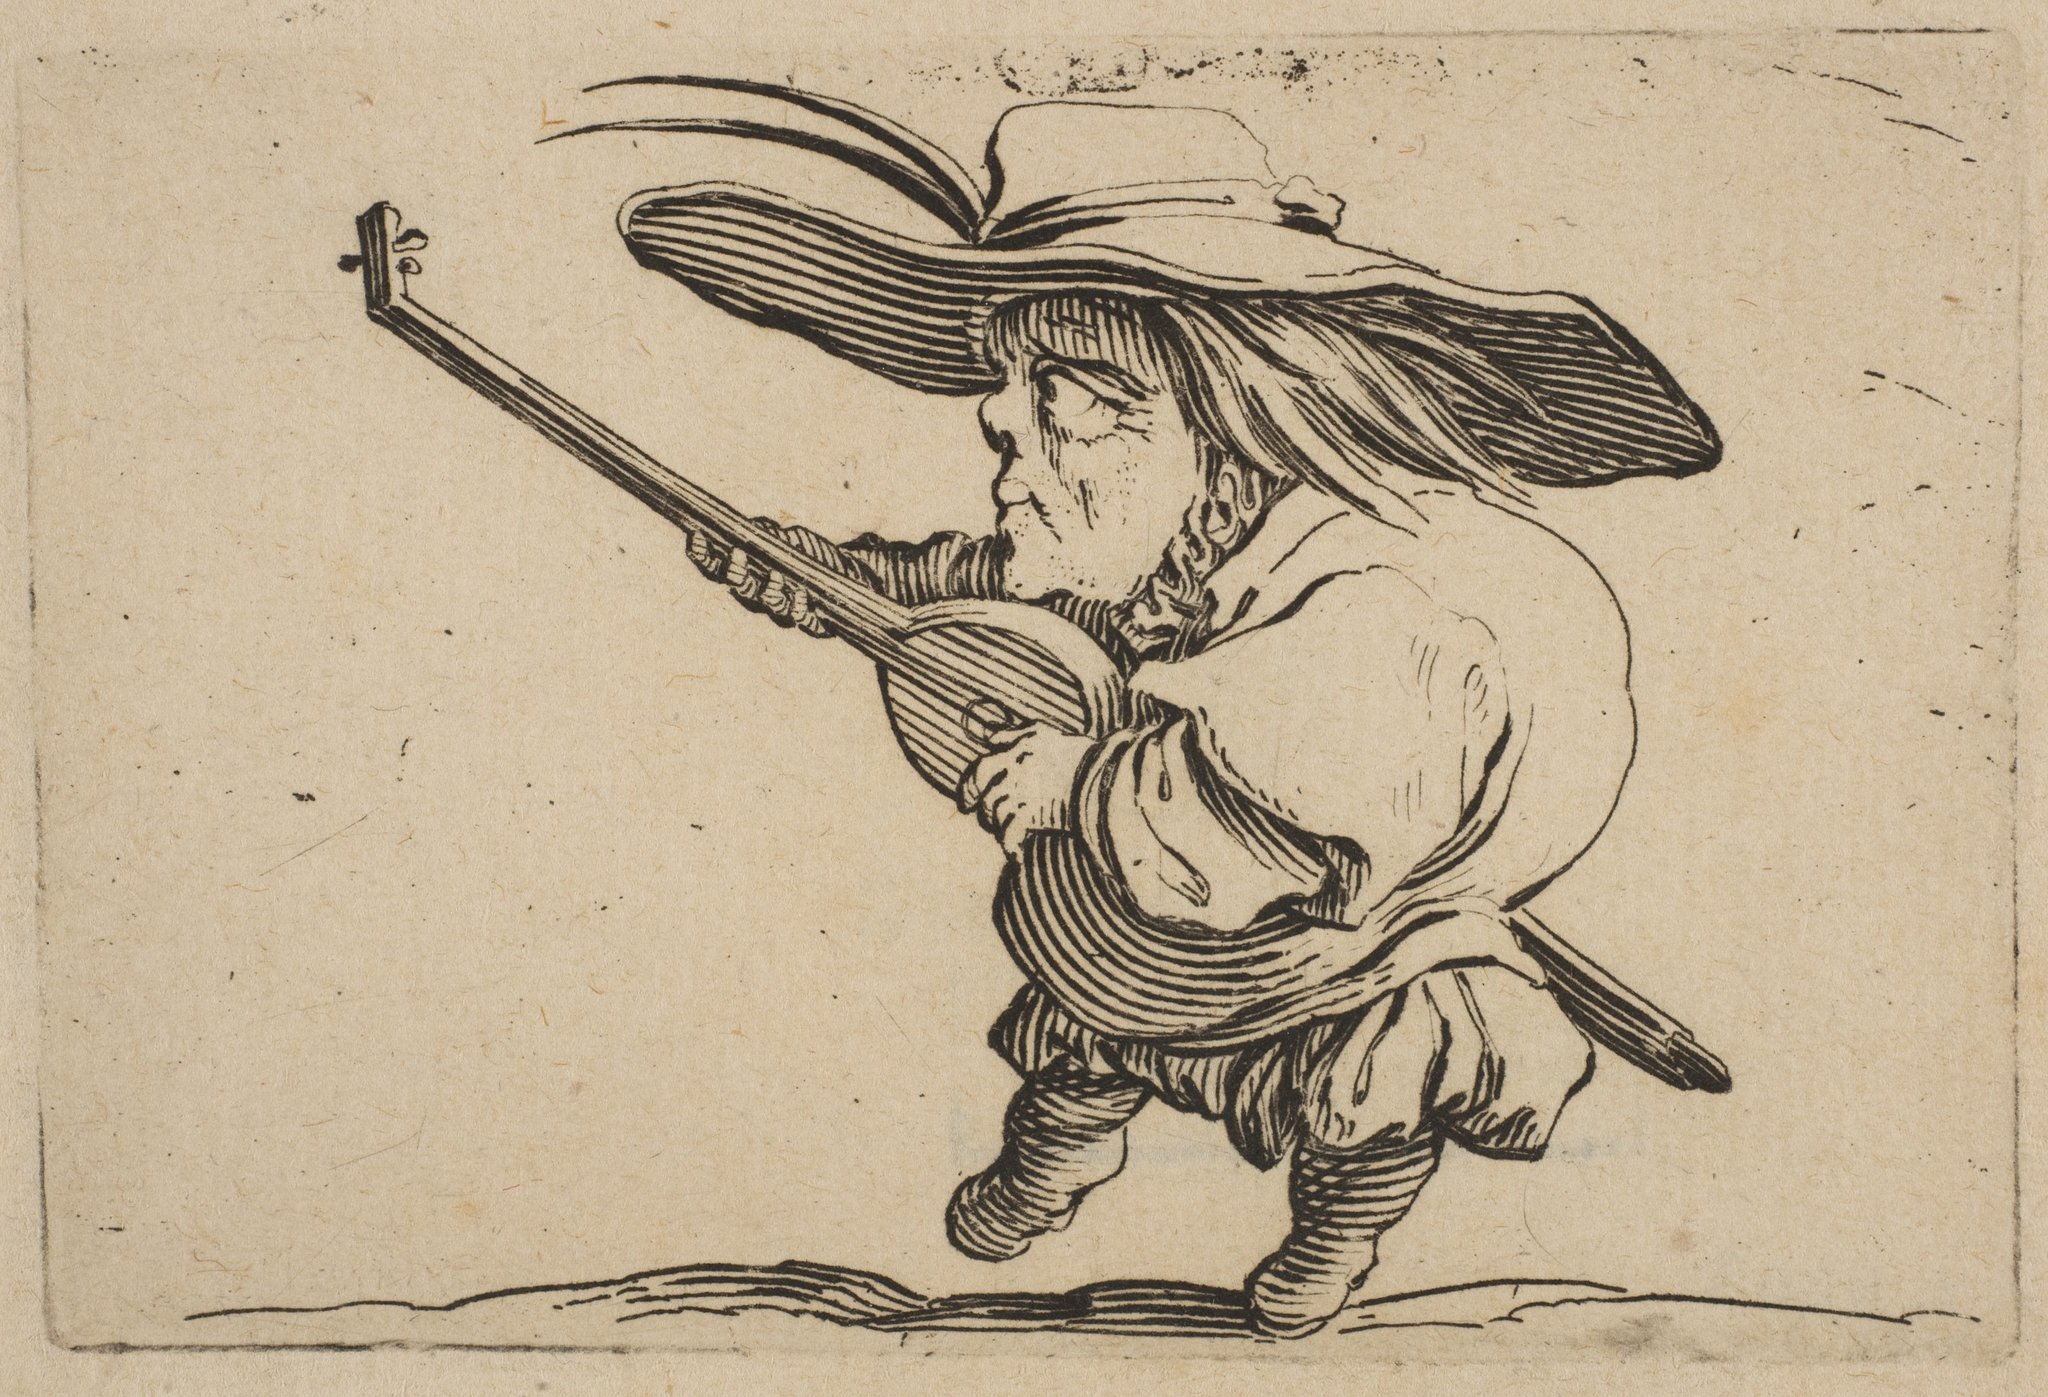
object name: print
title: Le Joeuer de Luth (The Lute Player), from "Varie Figure Gobbi, suite appelée aussi Les Bossus, Les Pygmées, Les Nains Grotesques" (Various Hunchbacked Figures, The Hunchbacks, The Pygmes, The Grotesque Dwarfs)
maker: jacques callot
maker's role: artist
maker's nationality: french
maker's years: 1592-1635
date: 1616-1622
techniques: engraving, etching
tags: men,music,lutes,musicians